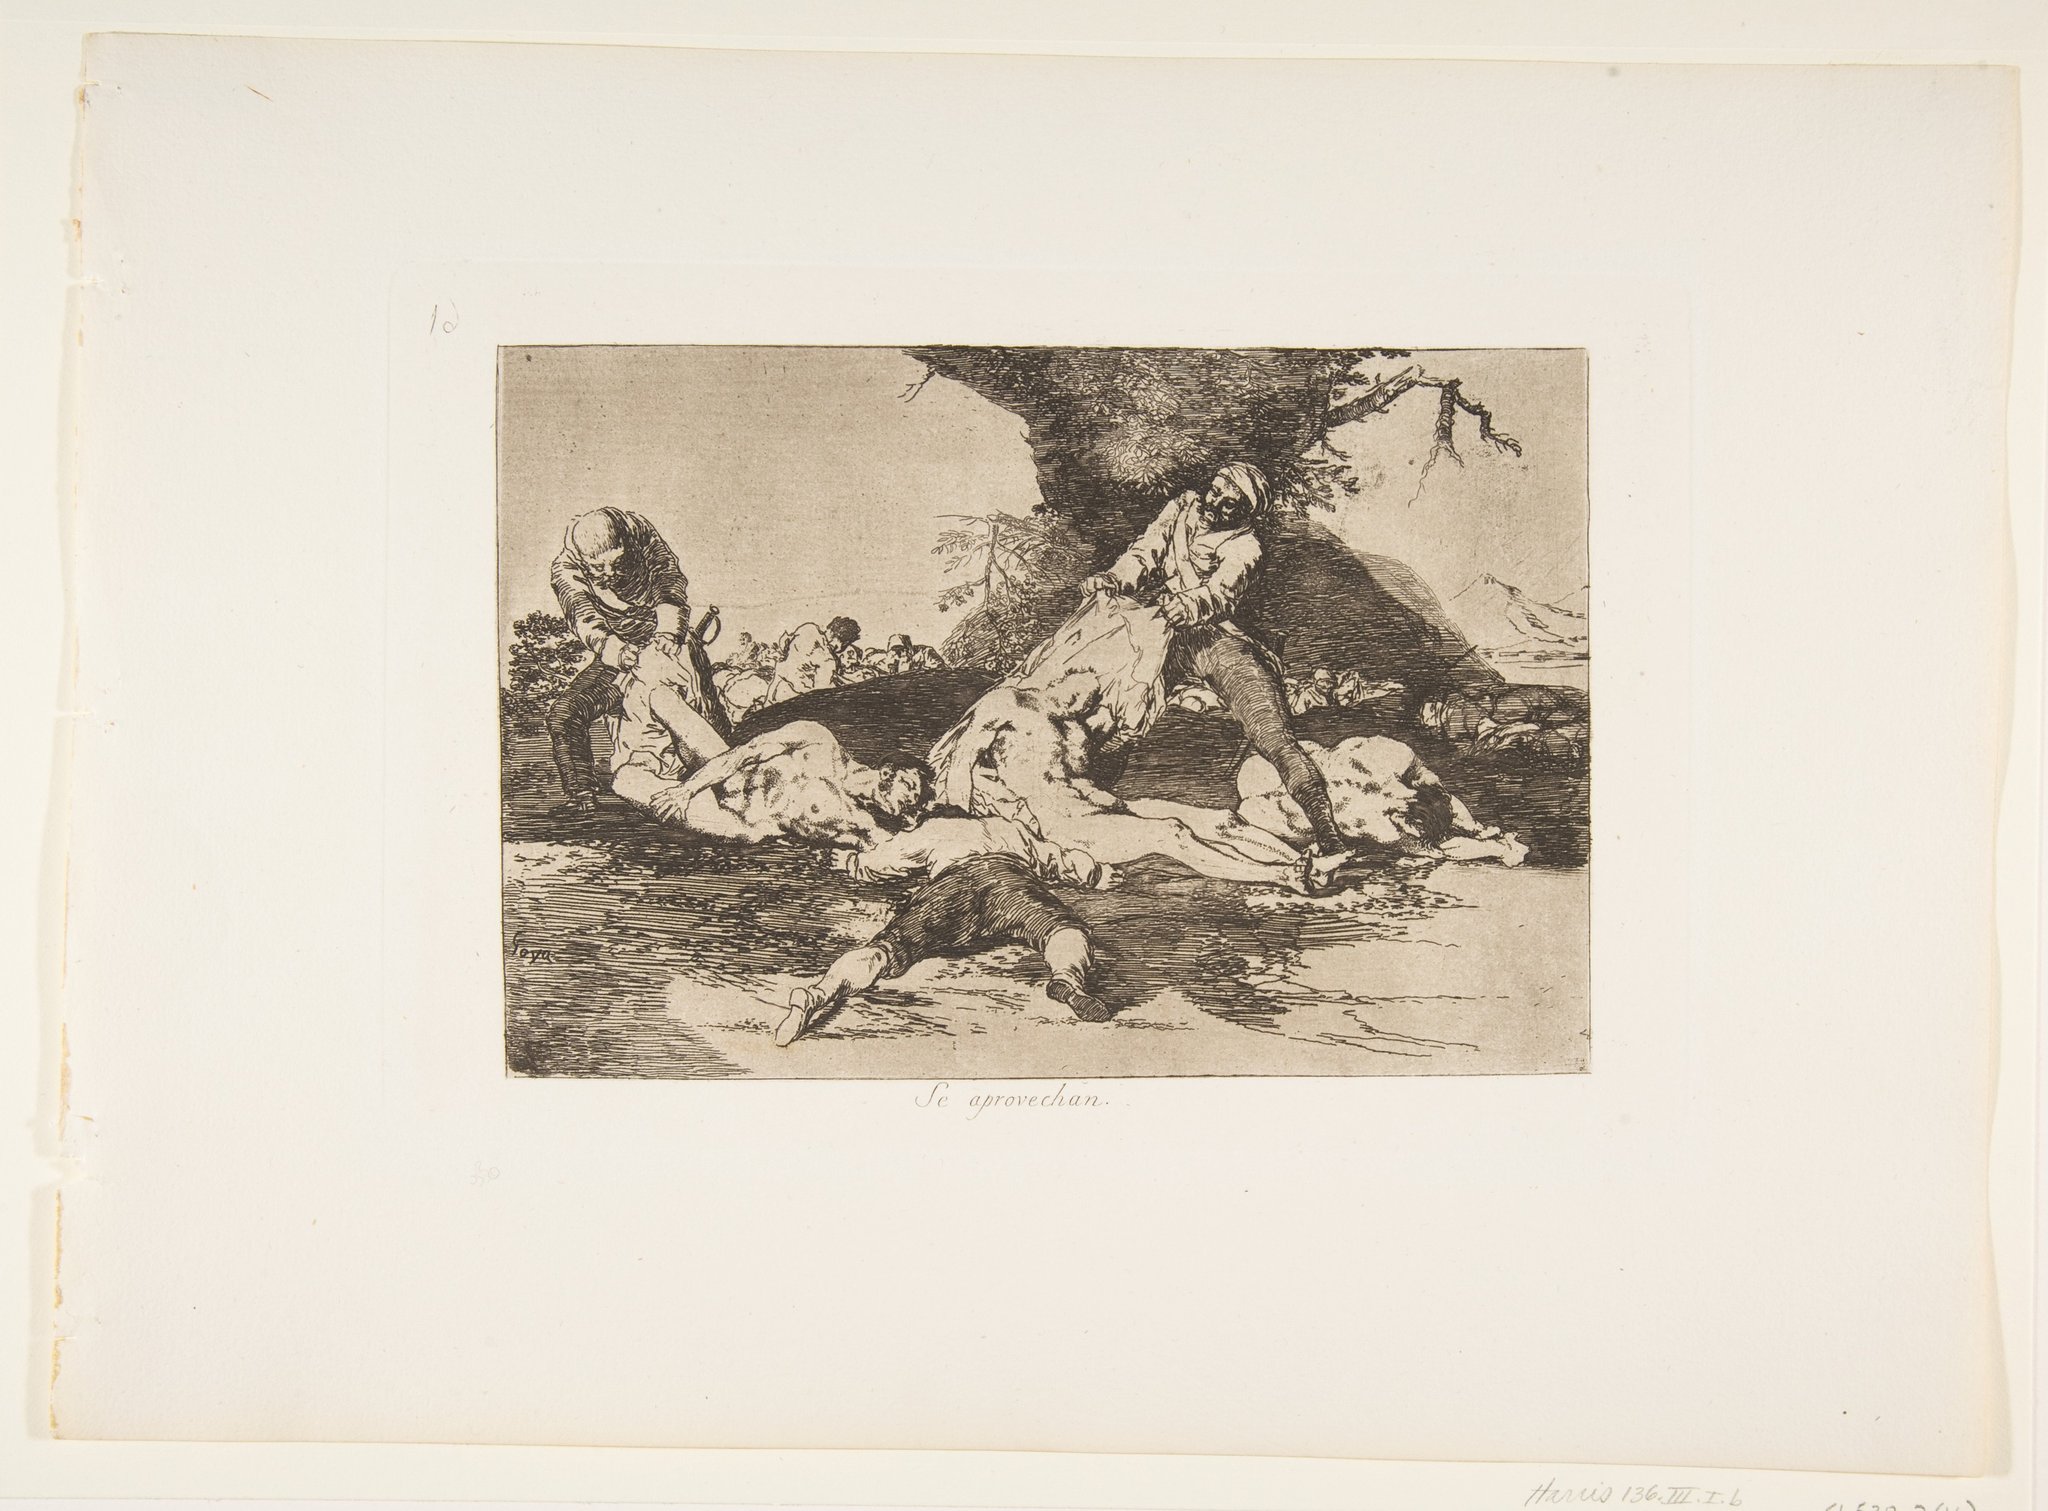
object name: print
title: Plate 16 from "The Disasters of War" (Los Desastres de La Guerra): They make use of them (Se aprovechan)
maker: goya (francisco de goya y lucientes)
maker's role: artist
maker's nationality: spanish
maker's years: 1746-1828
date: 1810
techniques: engraving, drypoint, etching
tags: soldiers,male nudes,death